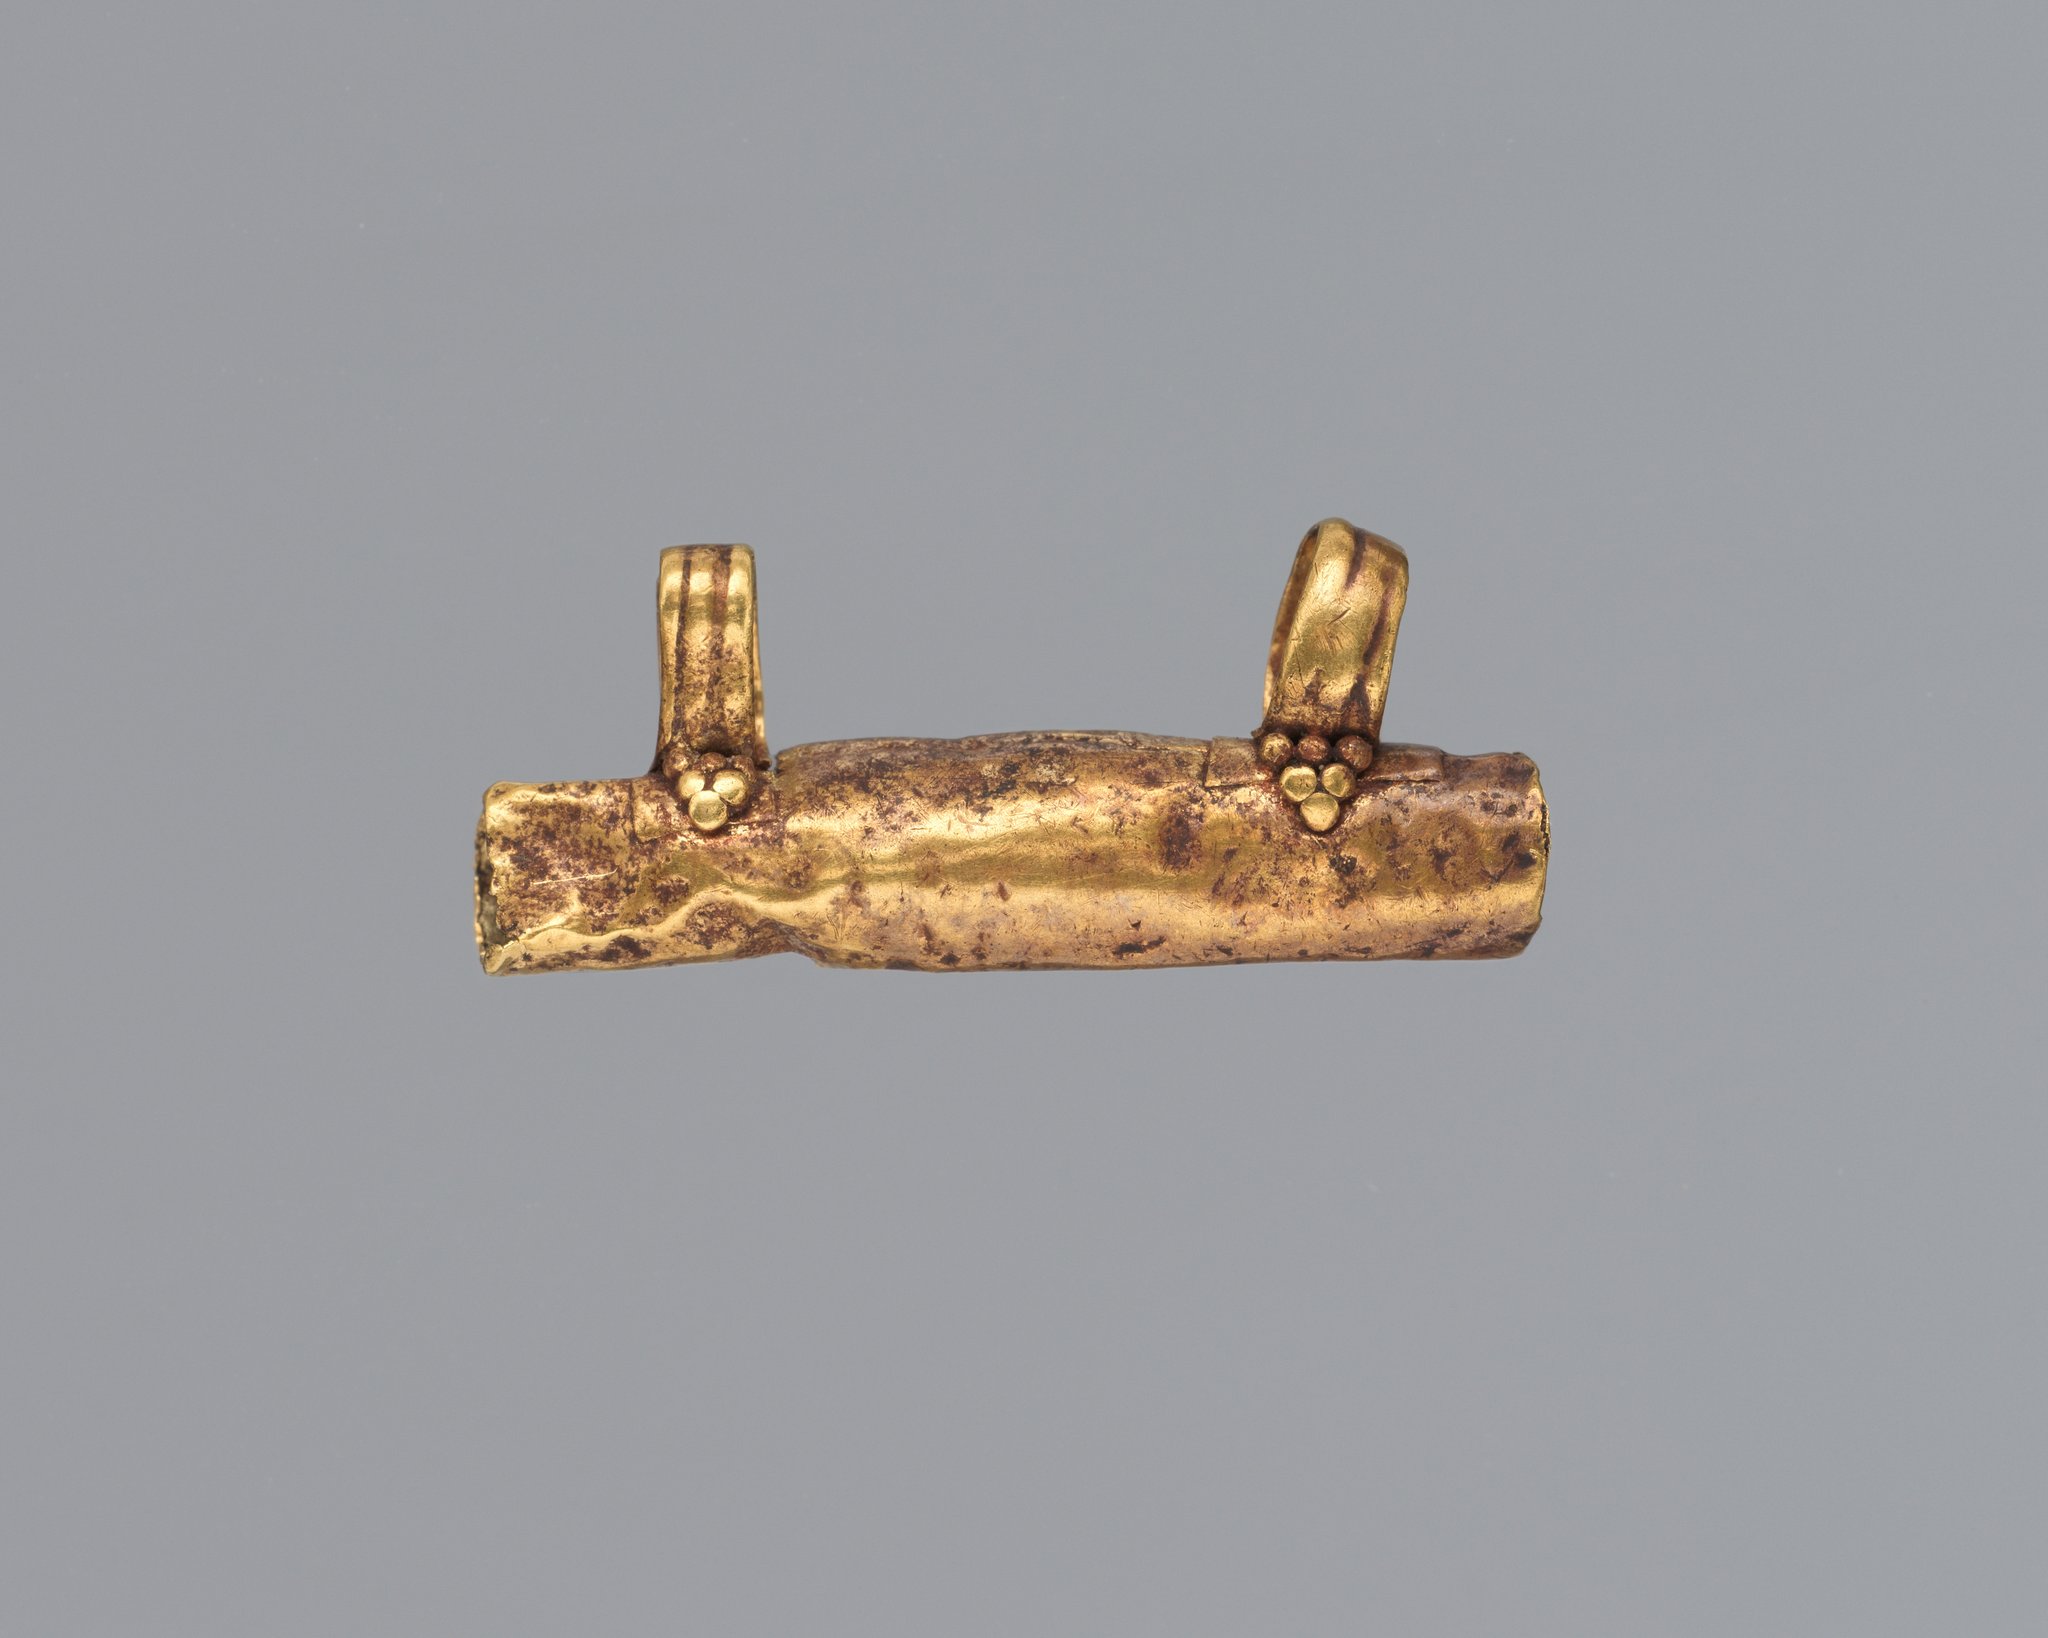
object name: bead pendant, tubular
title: Gold amulet case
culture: roman, cypriot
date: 1-300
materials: gold